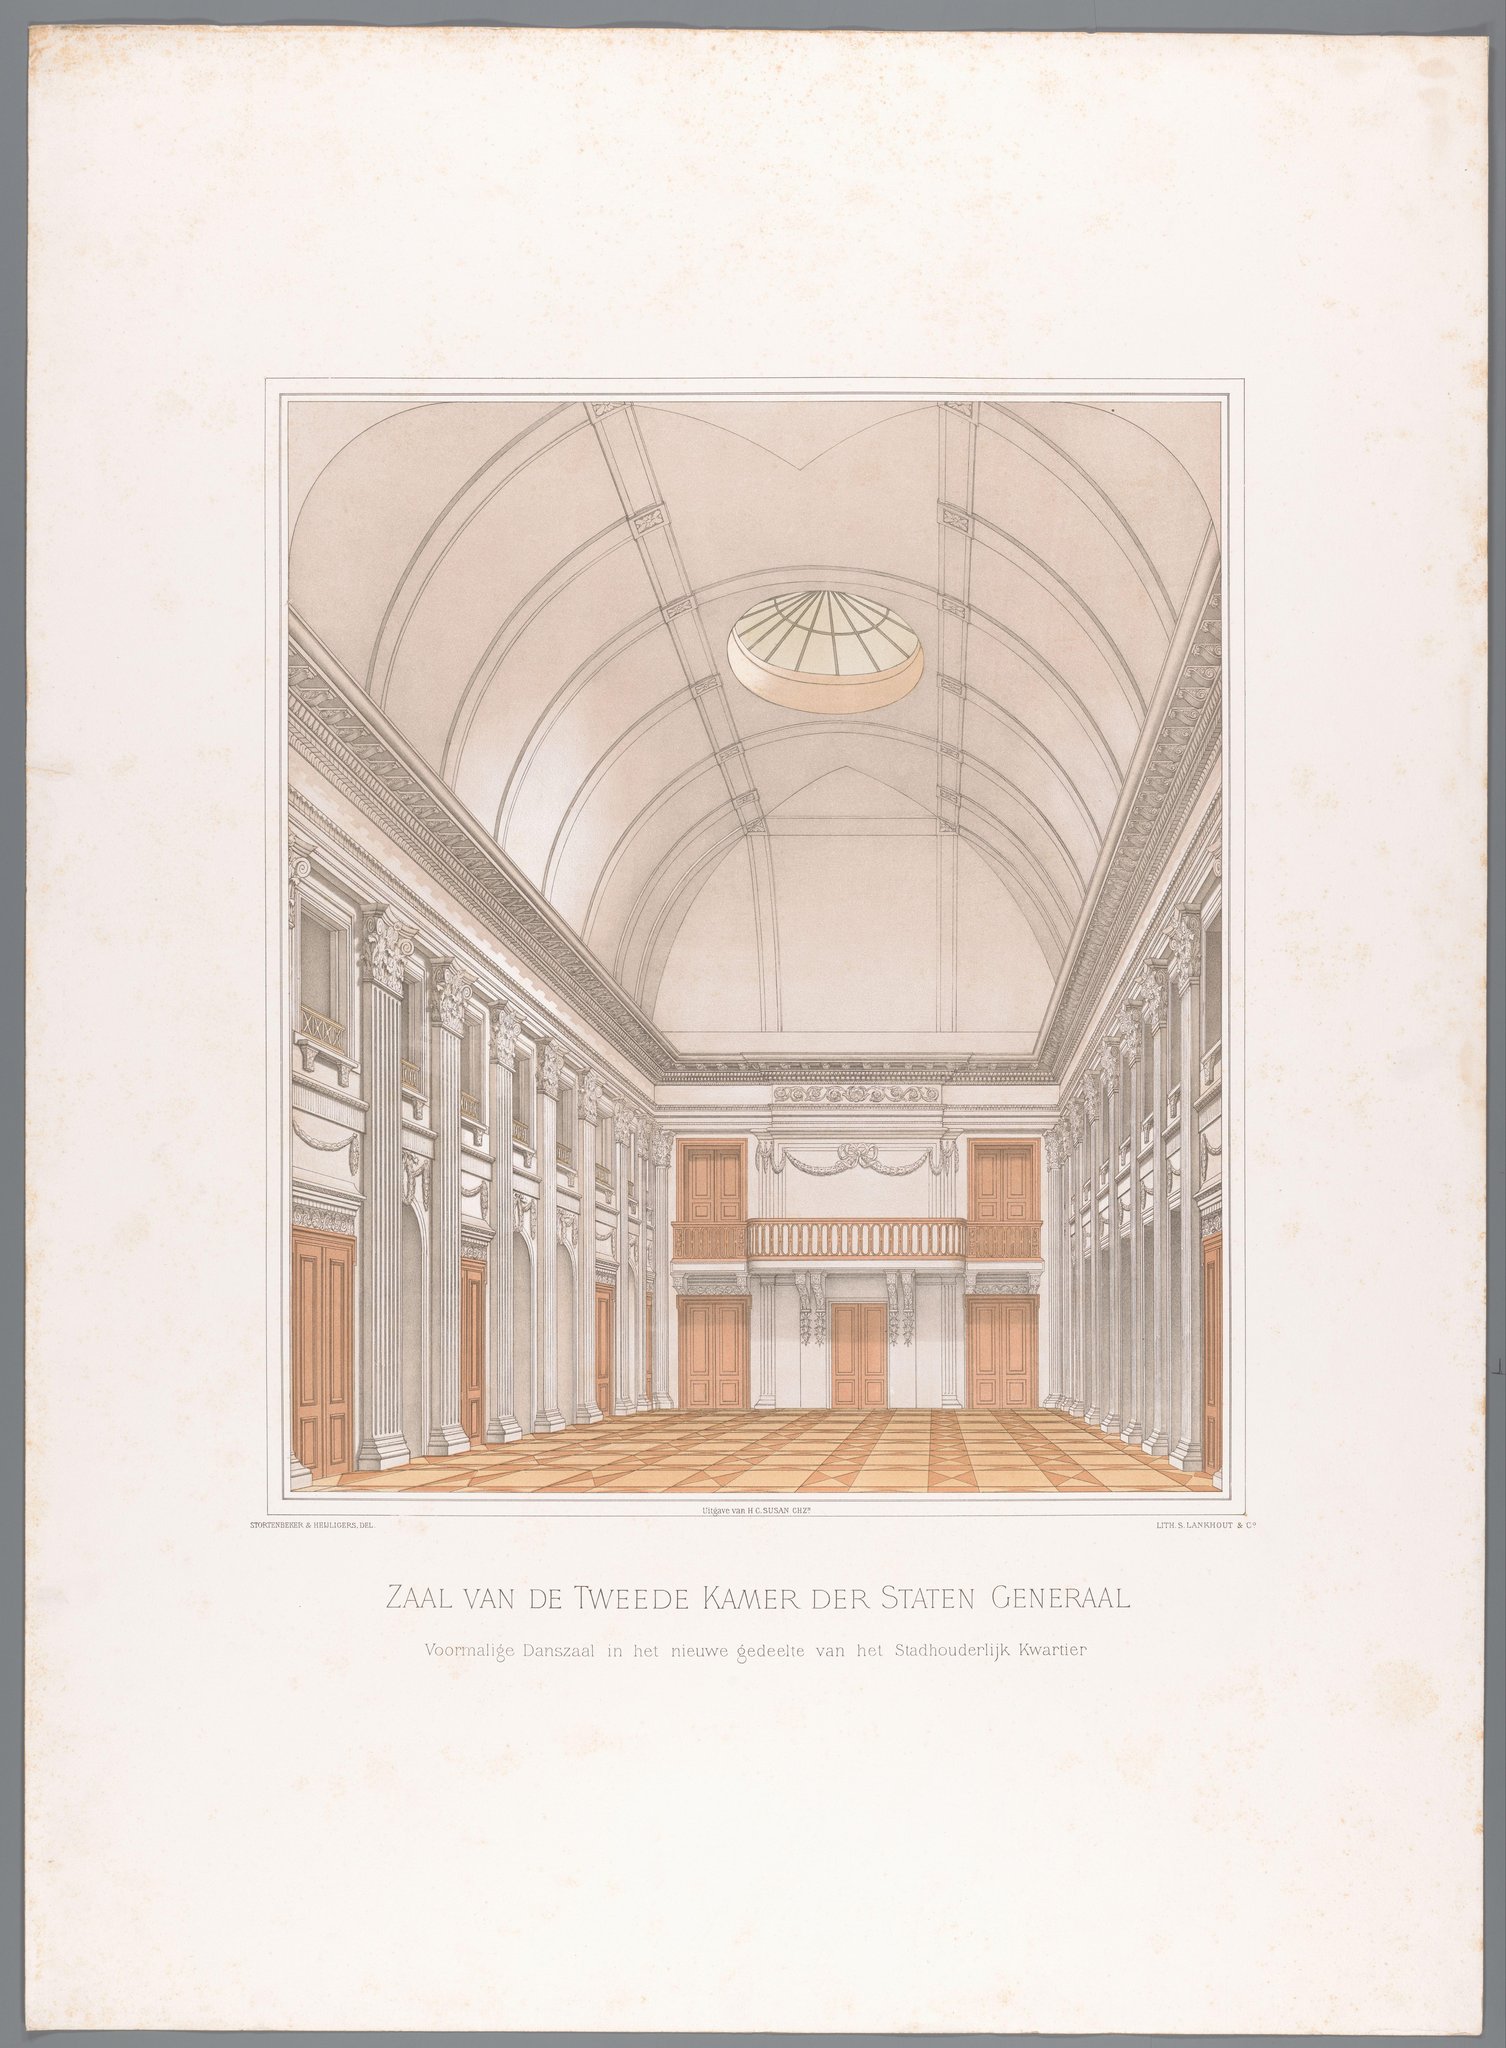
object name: print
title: Zaal van de Tweede Kamer der Staten Generaal, op het Binnenhof (...)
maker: h.c. susan chzn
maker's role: publisher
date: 1879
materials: paper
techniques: lithograph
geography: the hague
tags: national government